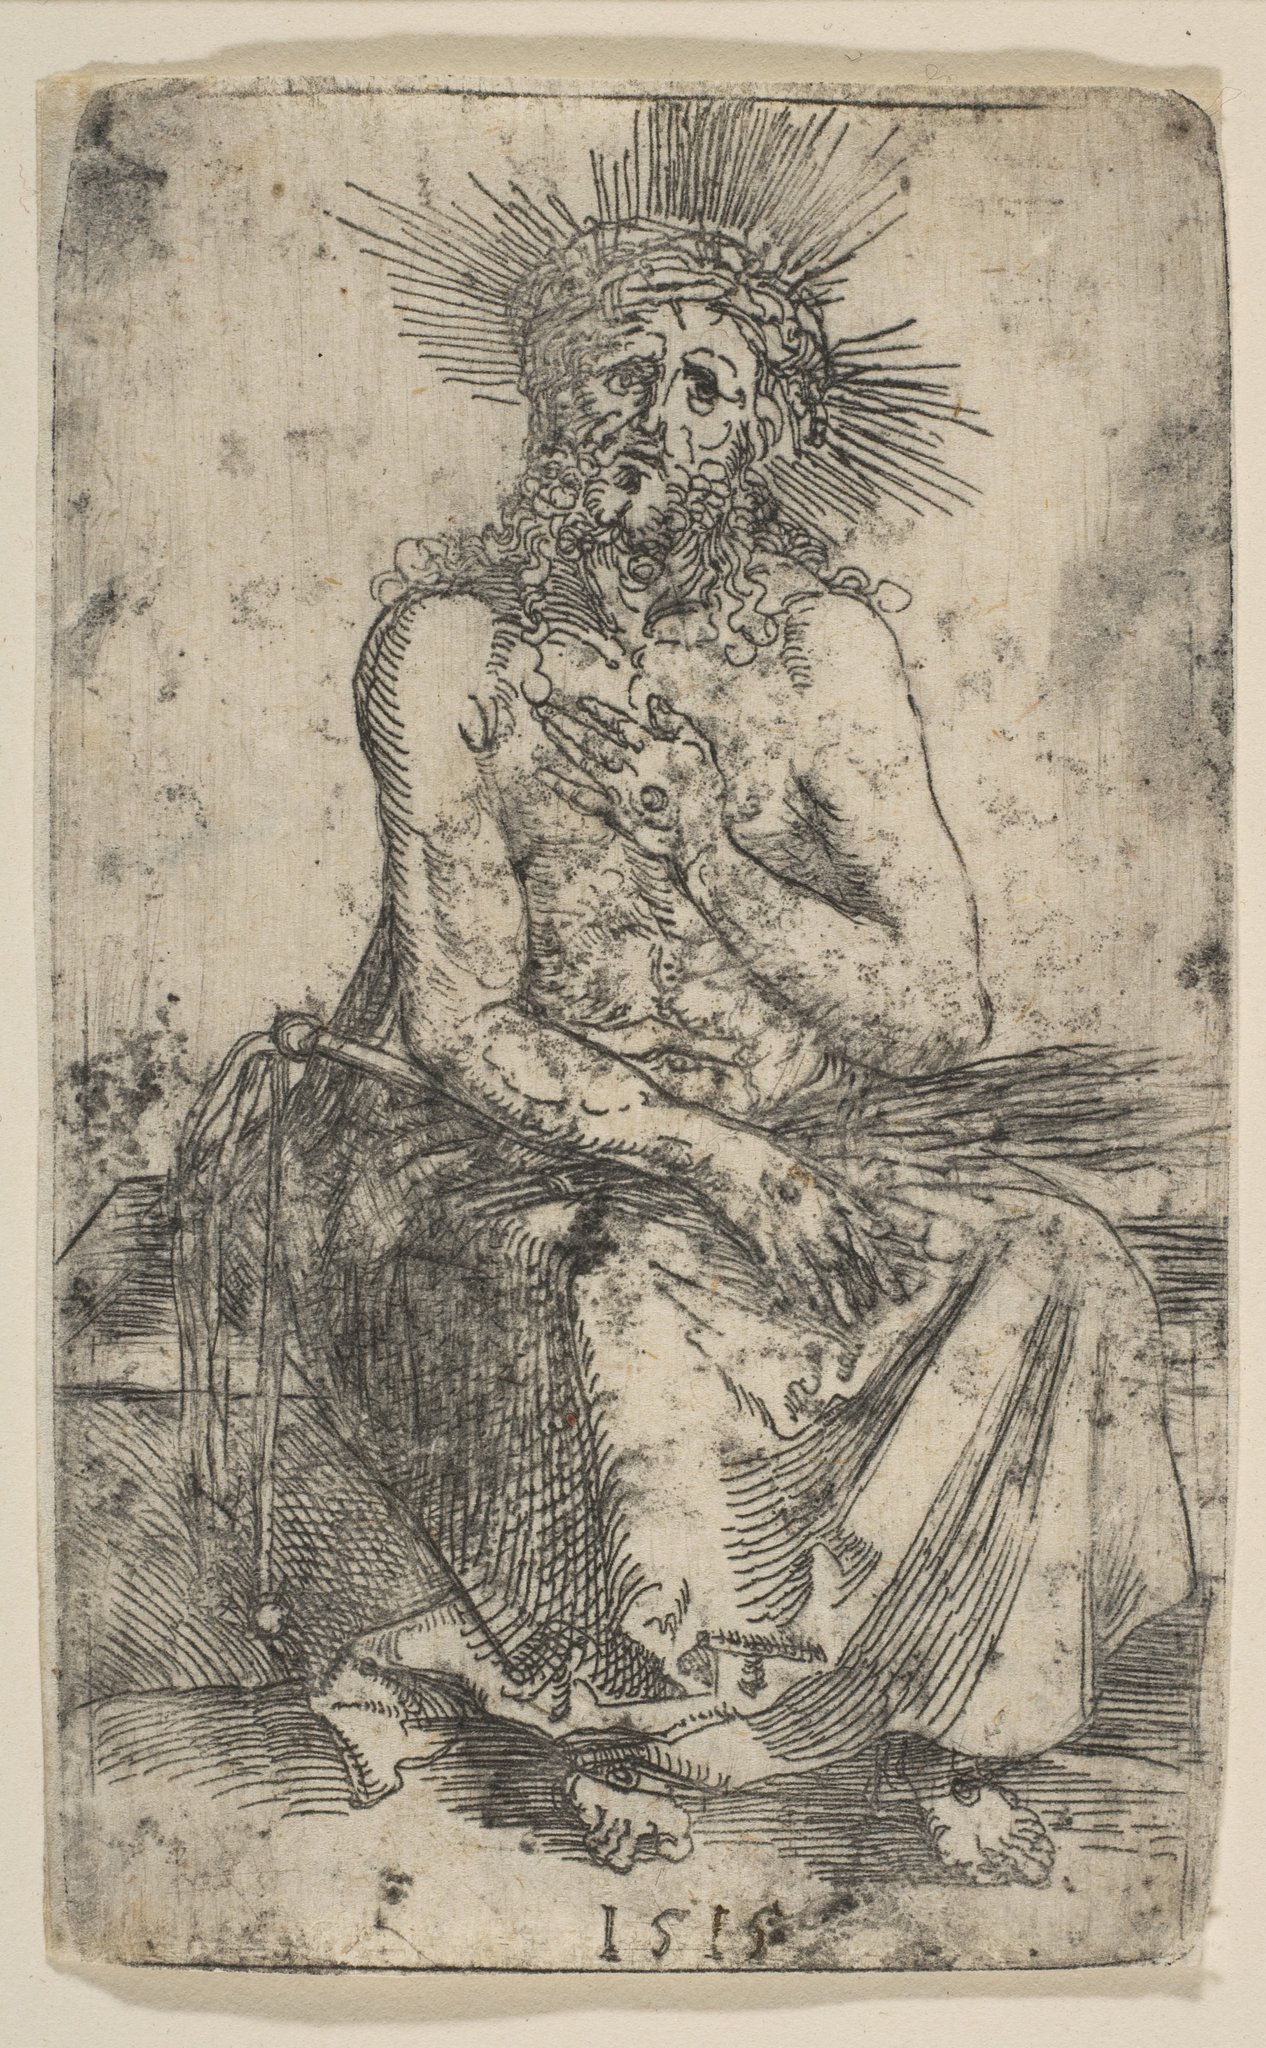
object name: print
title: The Man of Sorrows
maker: albrecht dürer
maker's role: artist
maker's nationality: german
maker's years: 1471-1528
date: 1515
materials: iron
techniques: etching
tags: christ